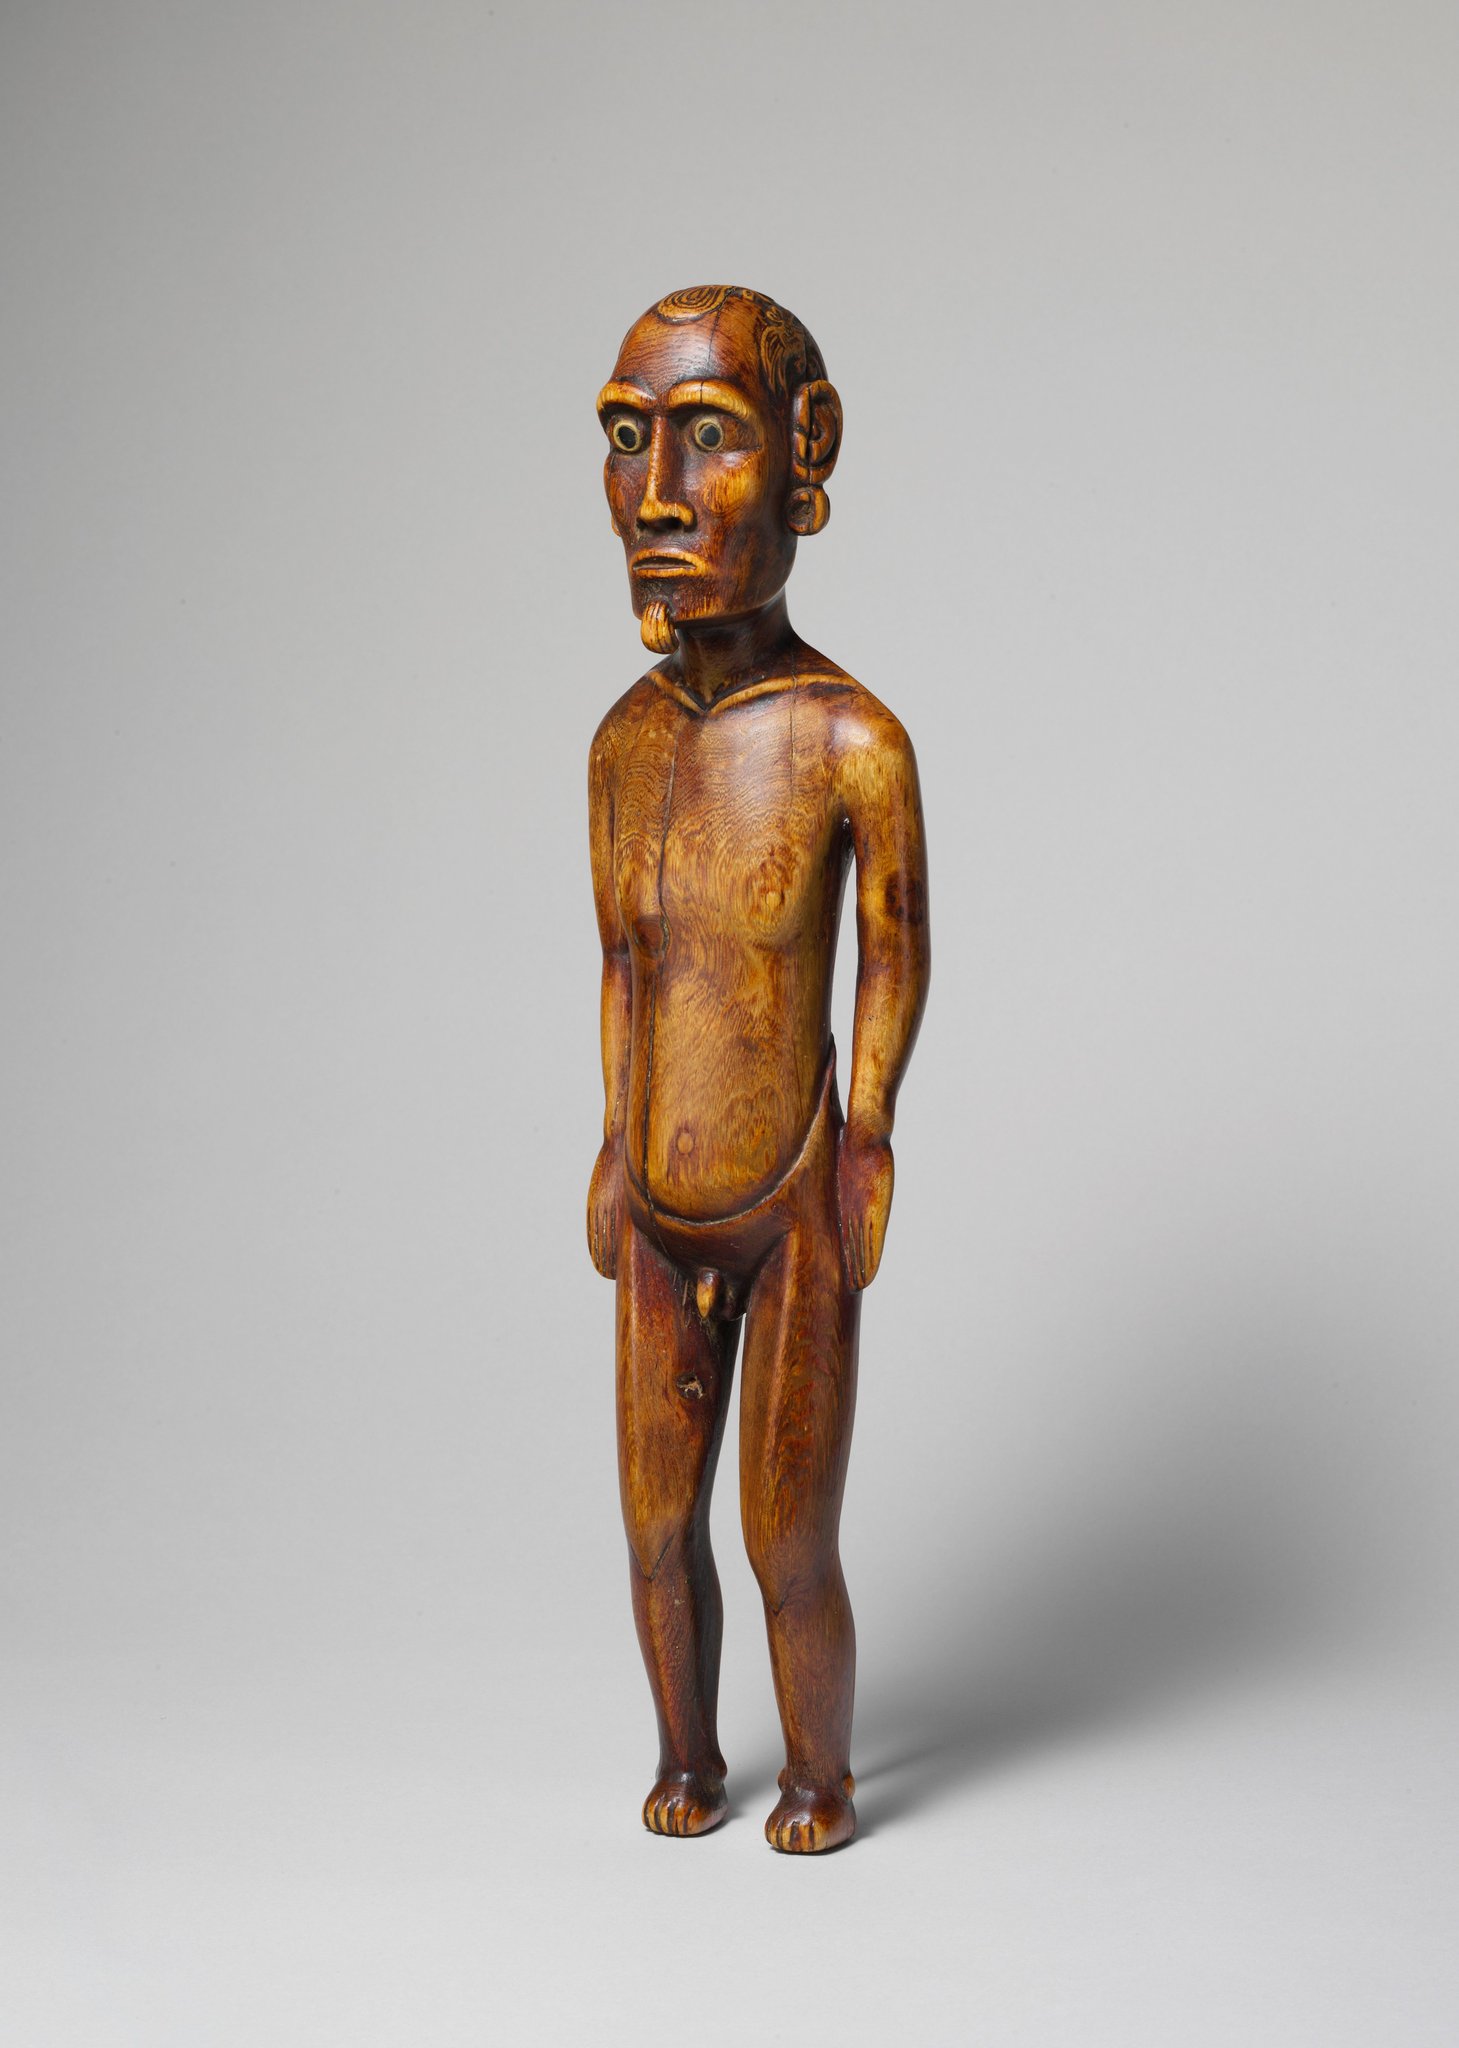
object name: figure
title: Male Figure (Moai Tangata)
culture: rapa nui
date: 1801-1833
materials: bone, obsidian, wood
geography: chile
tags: male nudes